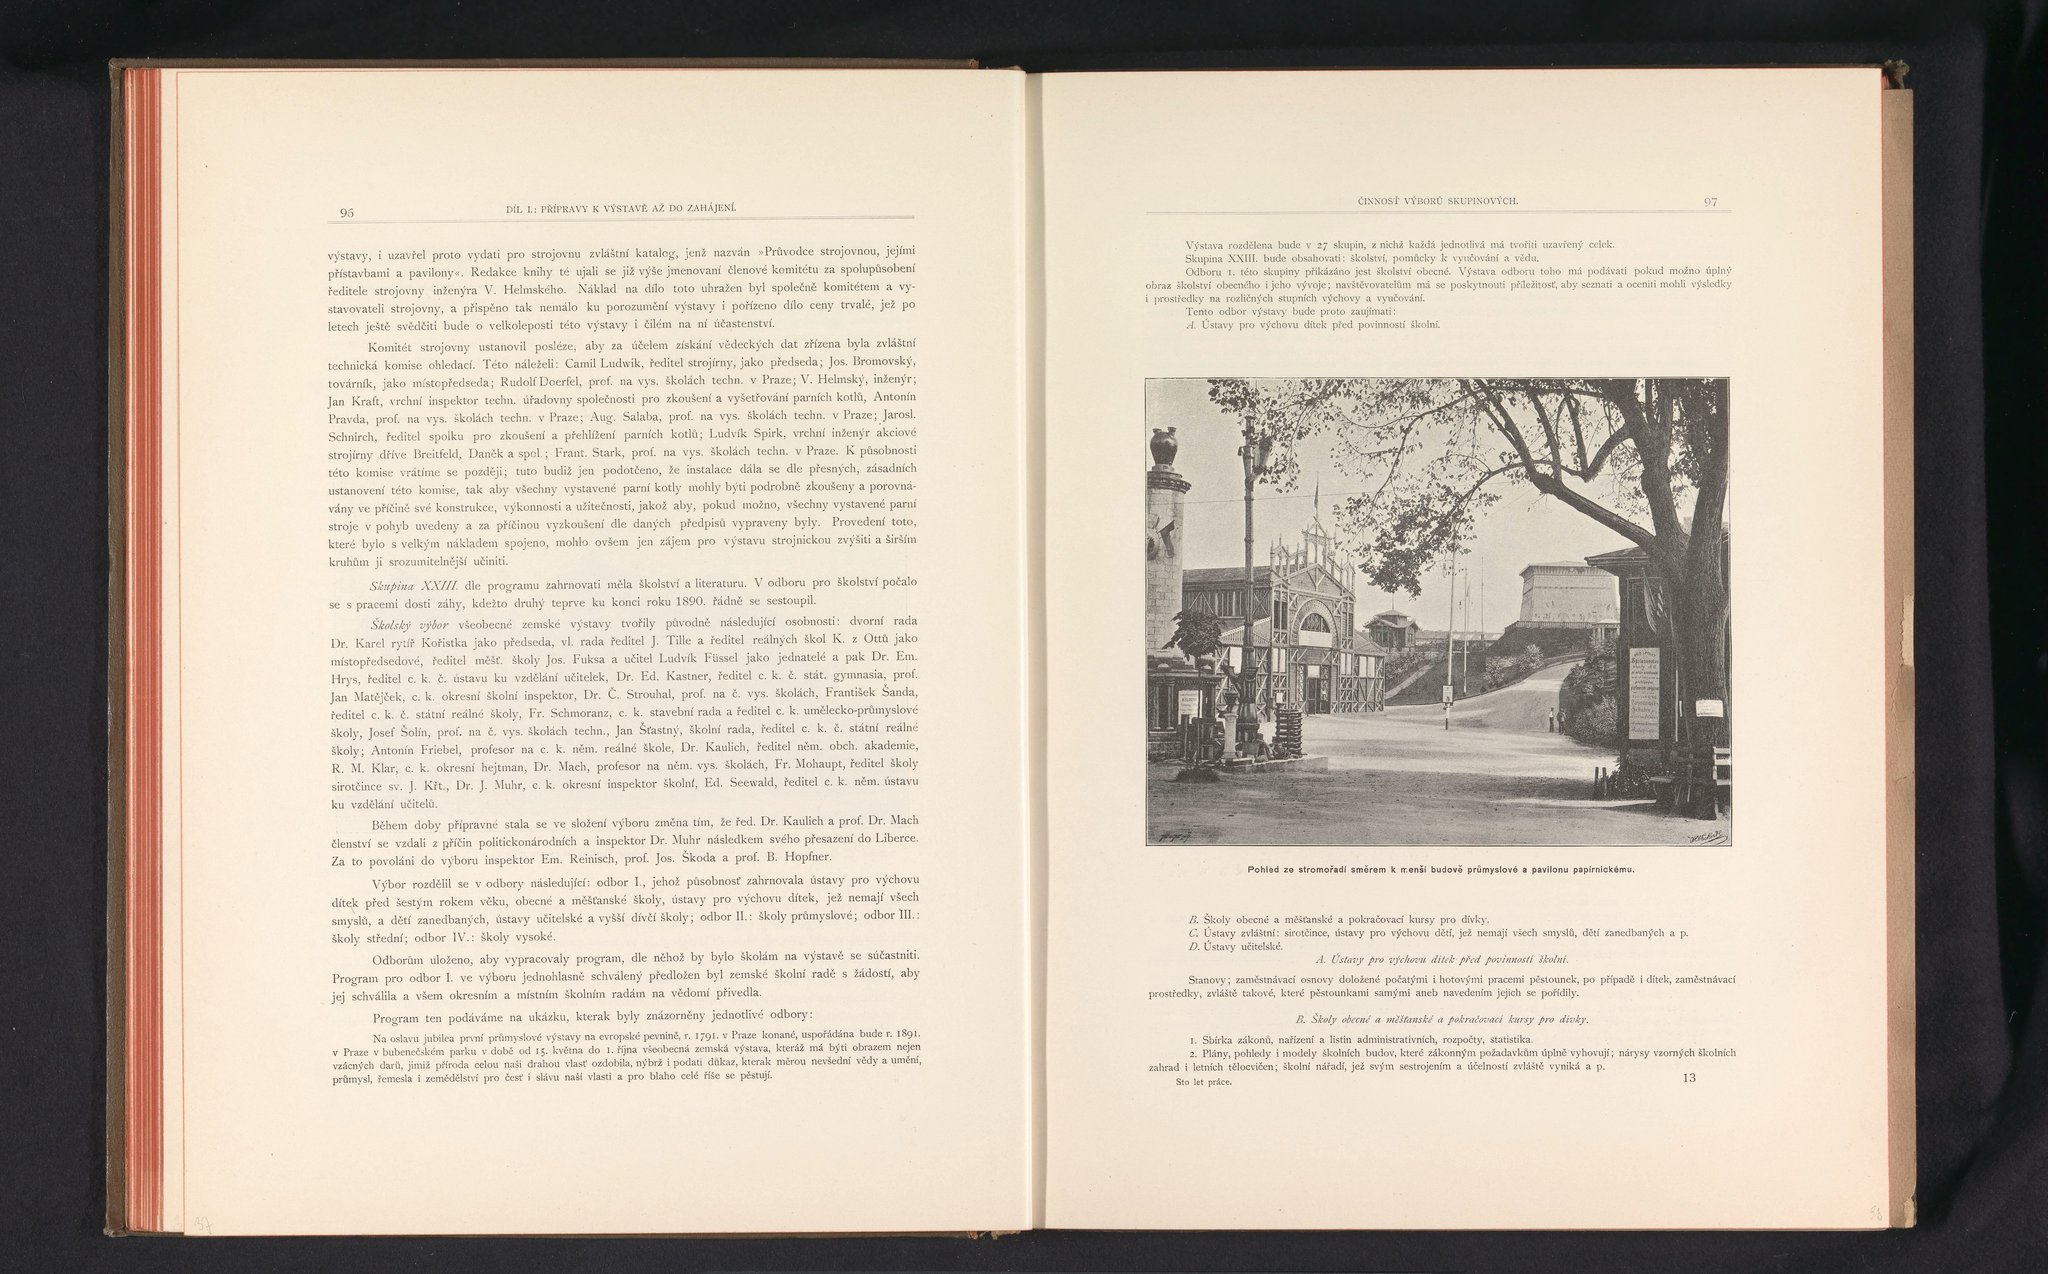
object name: photomechanical print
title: Pohled ze stromoradi smerem k mensi budove prumyslové a pavilonu papirnickému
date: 1888-1893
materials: paper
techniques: autotype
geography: prague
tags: housing, façade (of house or building)